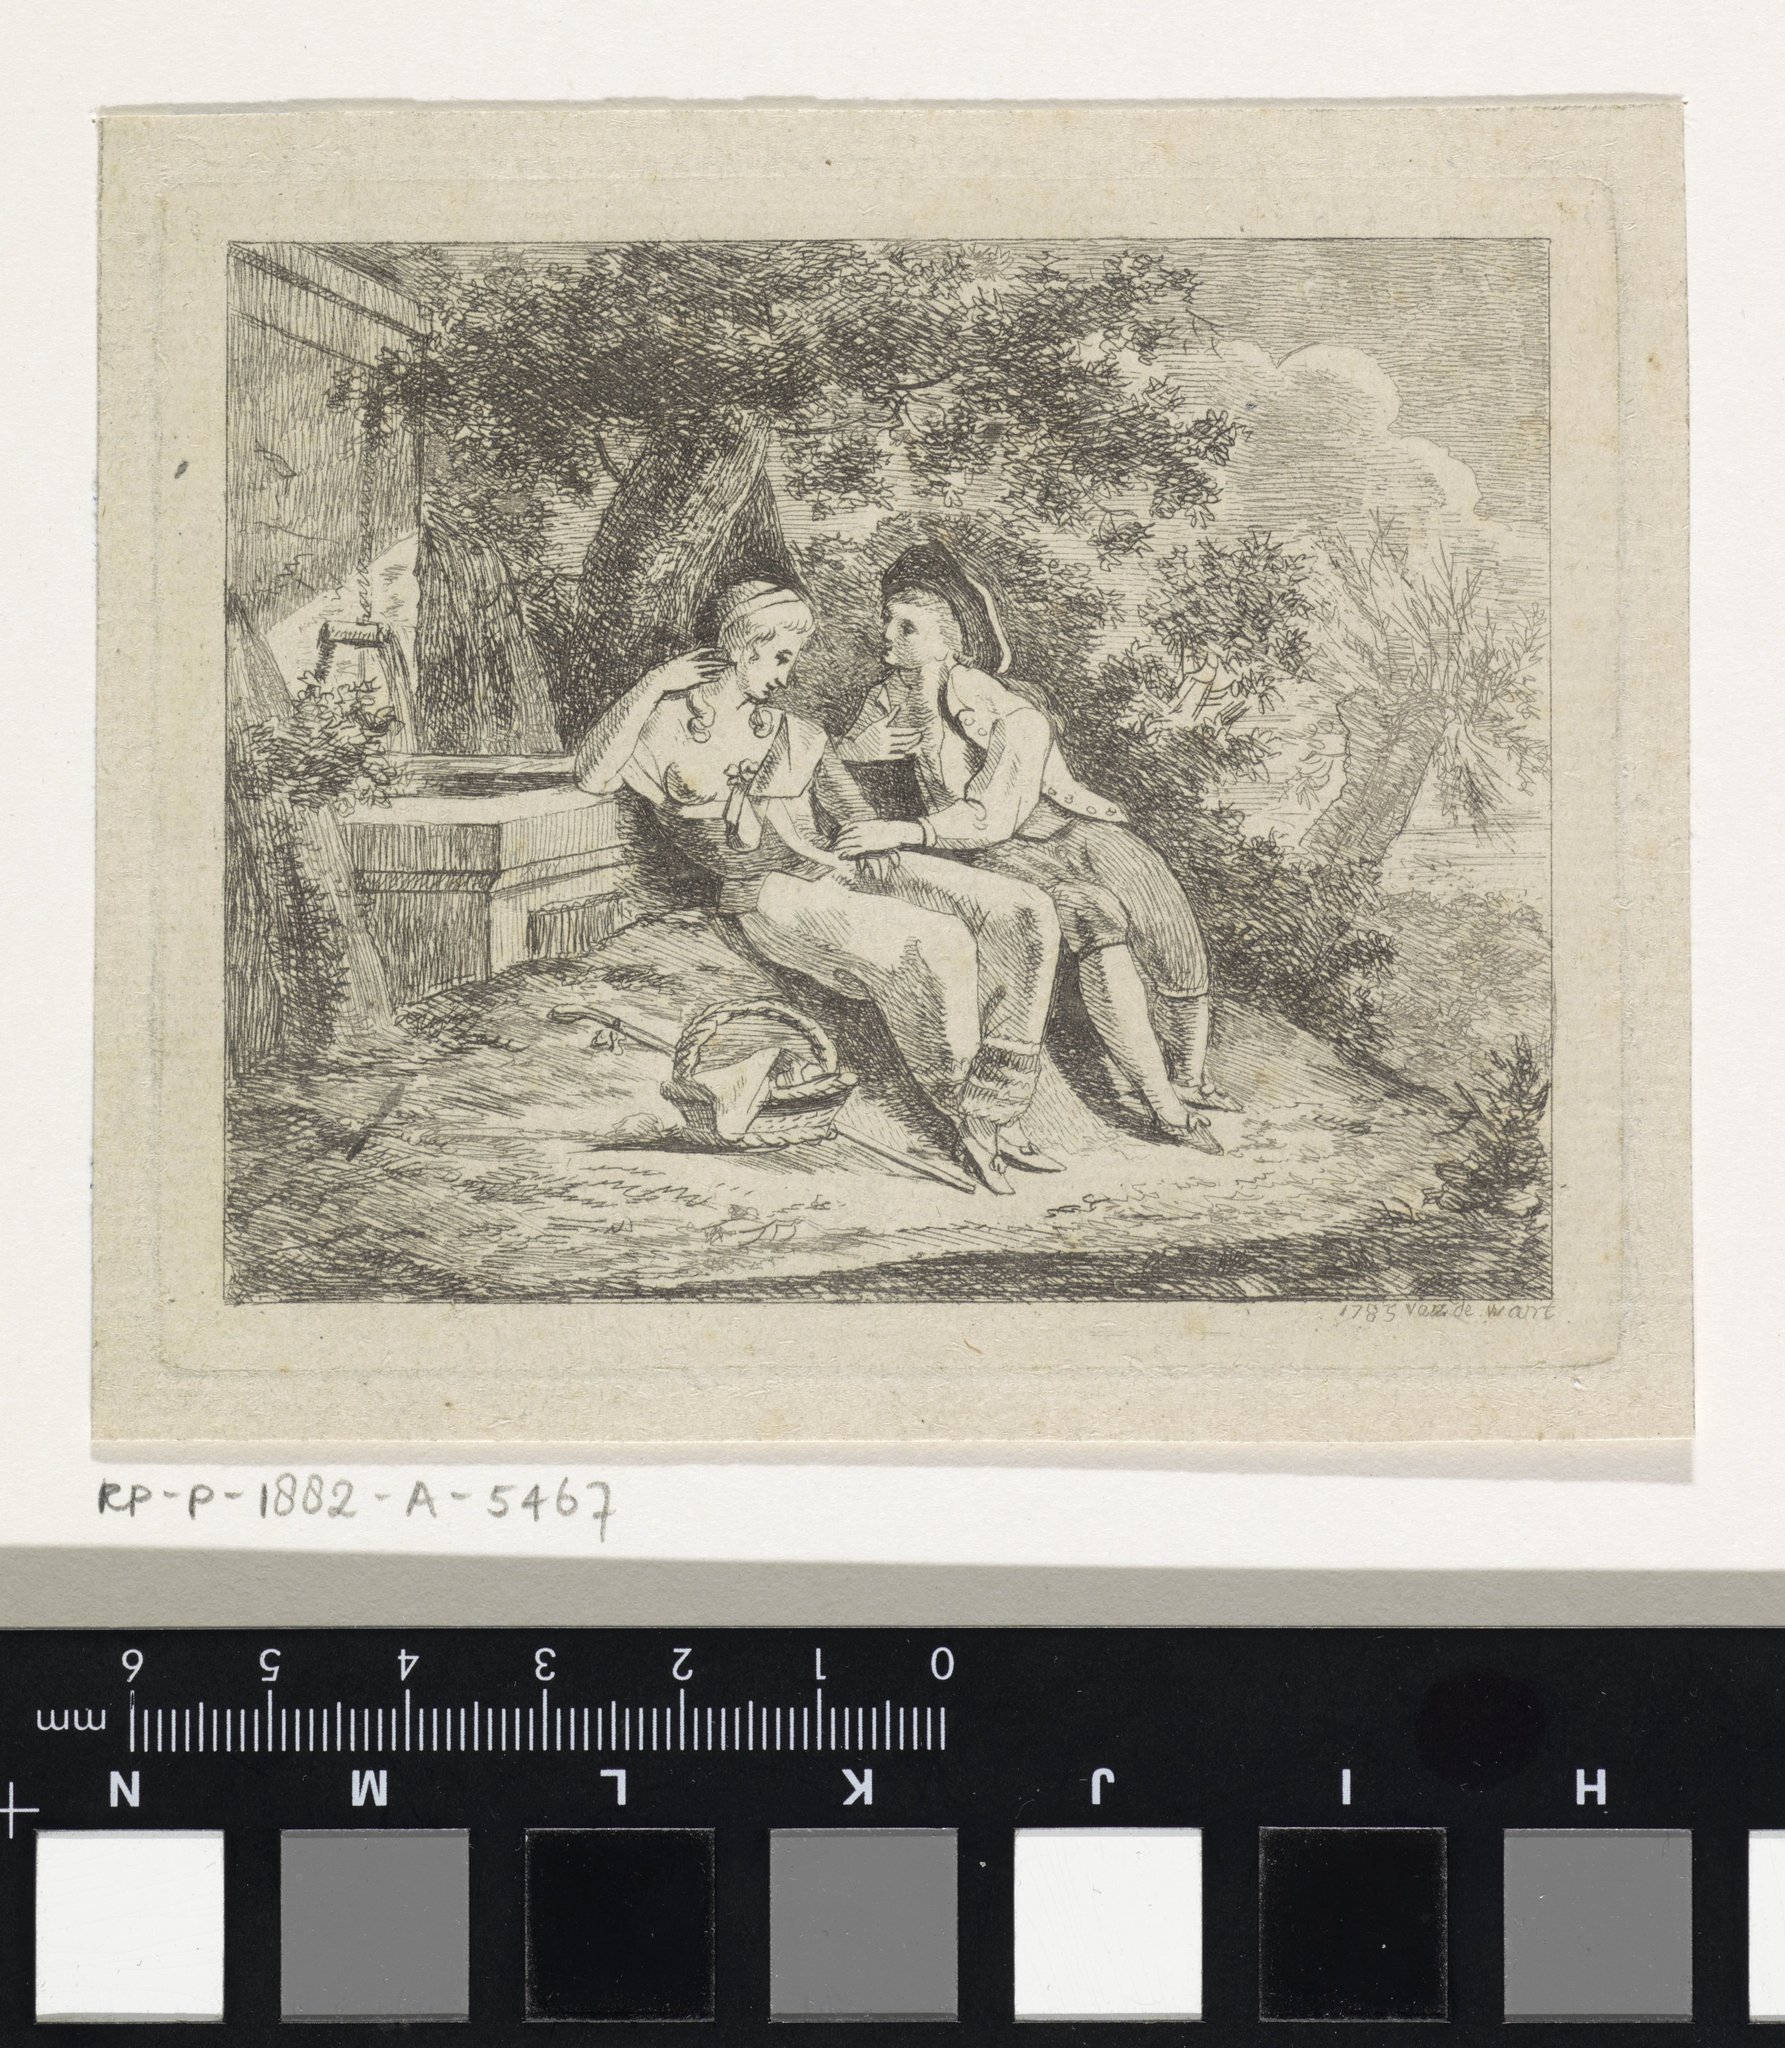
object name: print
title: Herder en herderin bij een waterbron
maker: derk anthony van de wart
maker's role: draughtsman, painter, print maker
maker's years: 1767-1824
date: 1785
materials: paper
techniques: etching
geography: amsterdam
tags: herding, herdsman, herdswoman, shepherd, shepherdess, cowherd, etc., garden fountain, container made of plant material other than wood: basket, pastorals, arcadian scenes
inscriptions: collector's mark: Lugt 2228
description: Een herder zit naast een herderin met een ontblote borst. Zijn hand rust op haar hand. Naast haar ligt een herdersstaf naast een mand. Ze leunt op de fontein achter haar.